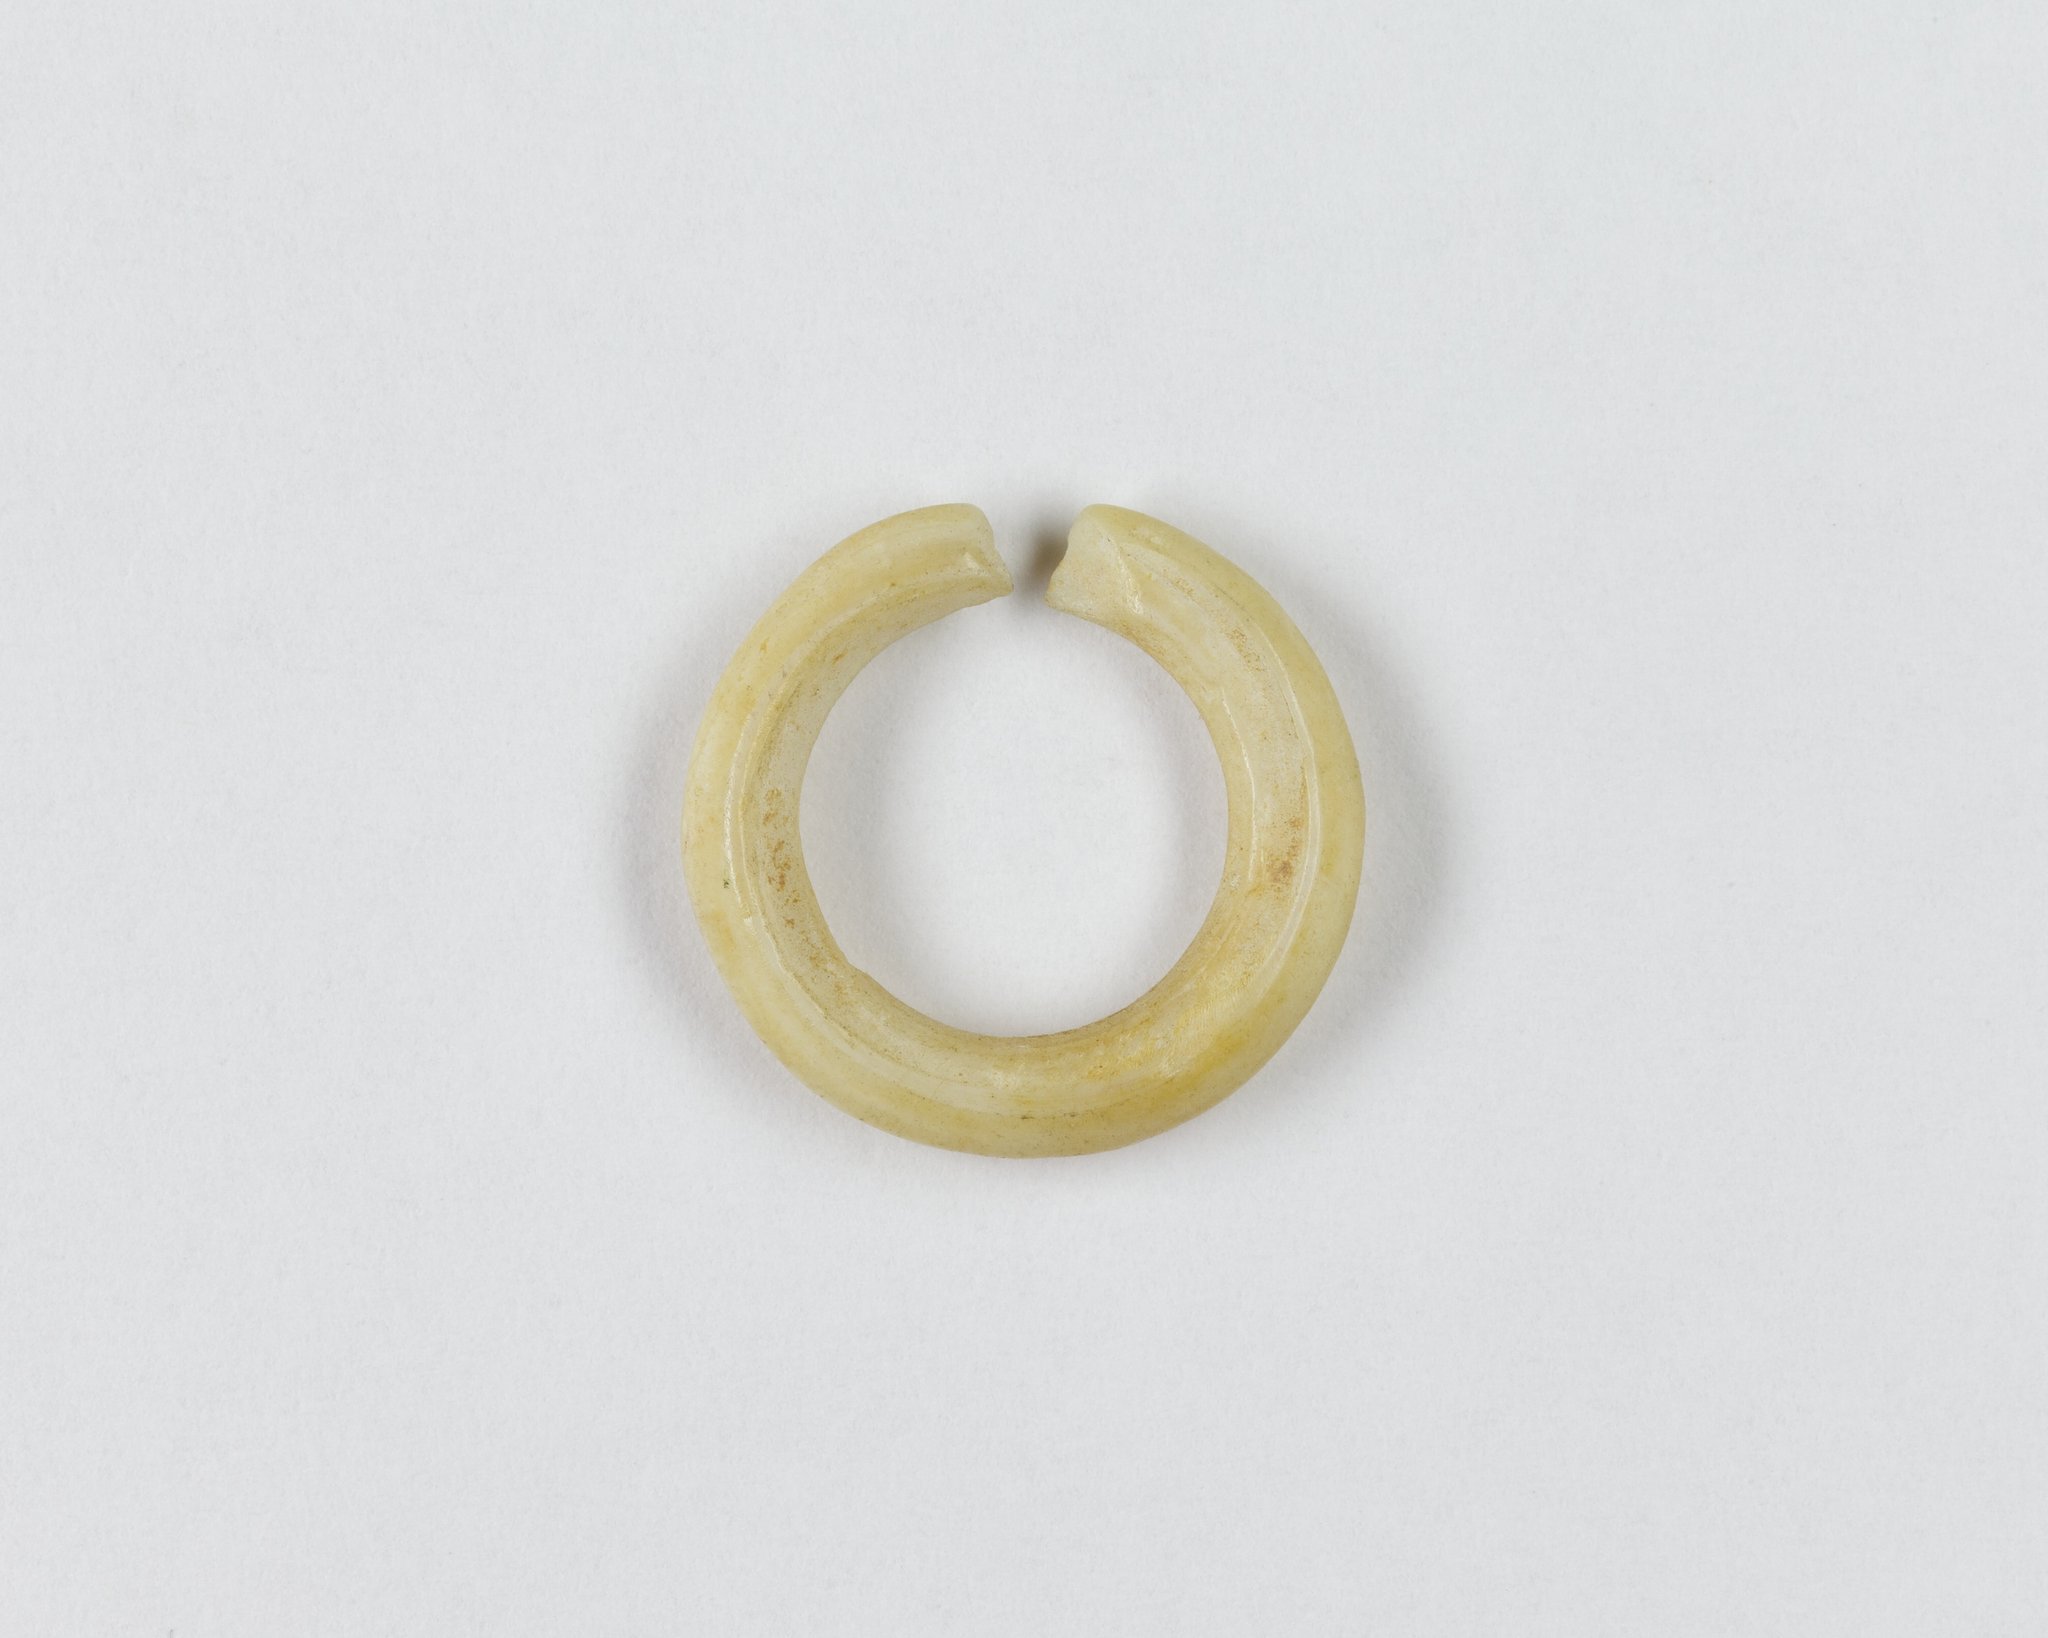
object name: earring, penannular, circular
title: Penannular Earring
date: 1550-1295 BCE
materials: shell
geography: northern upper egypt